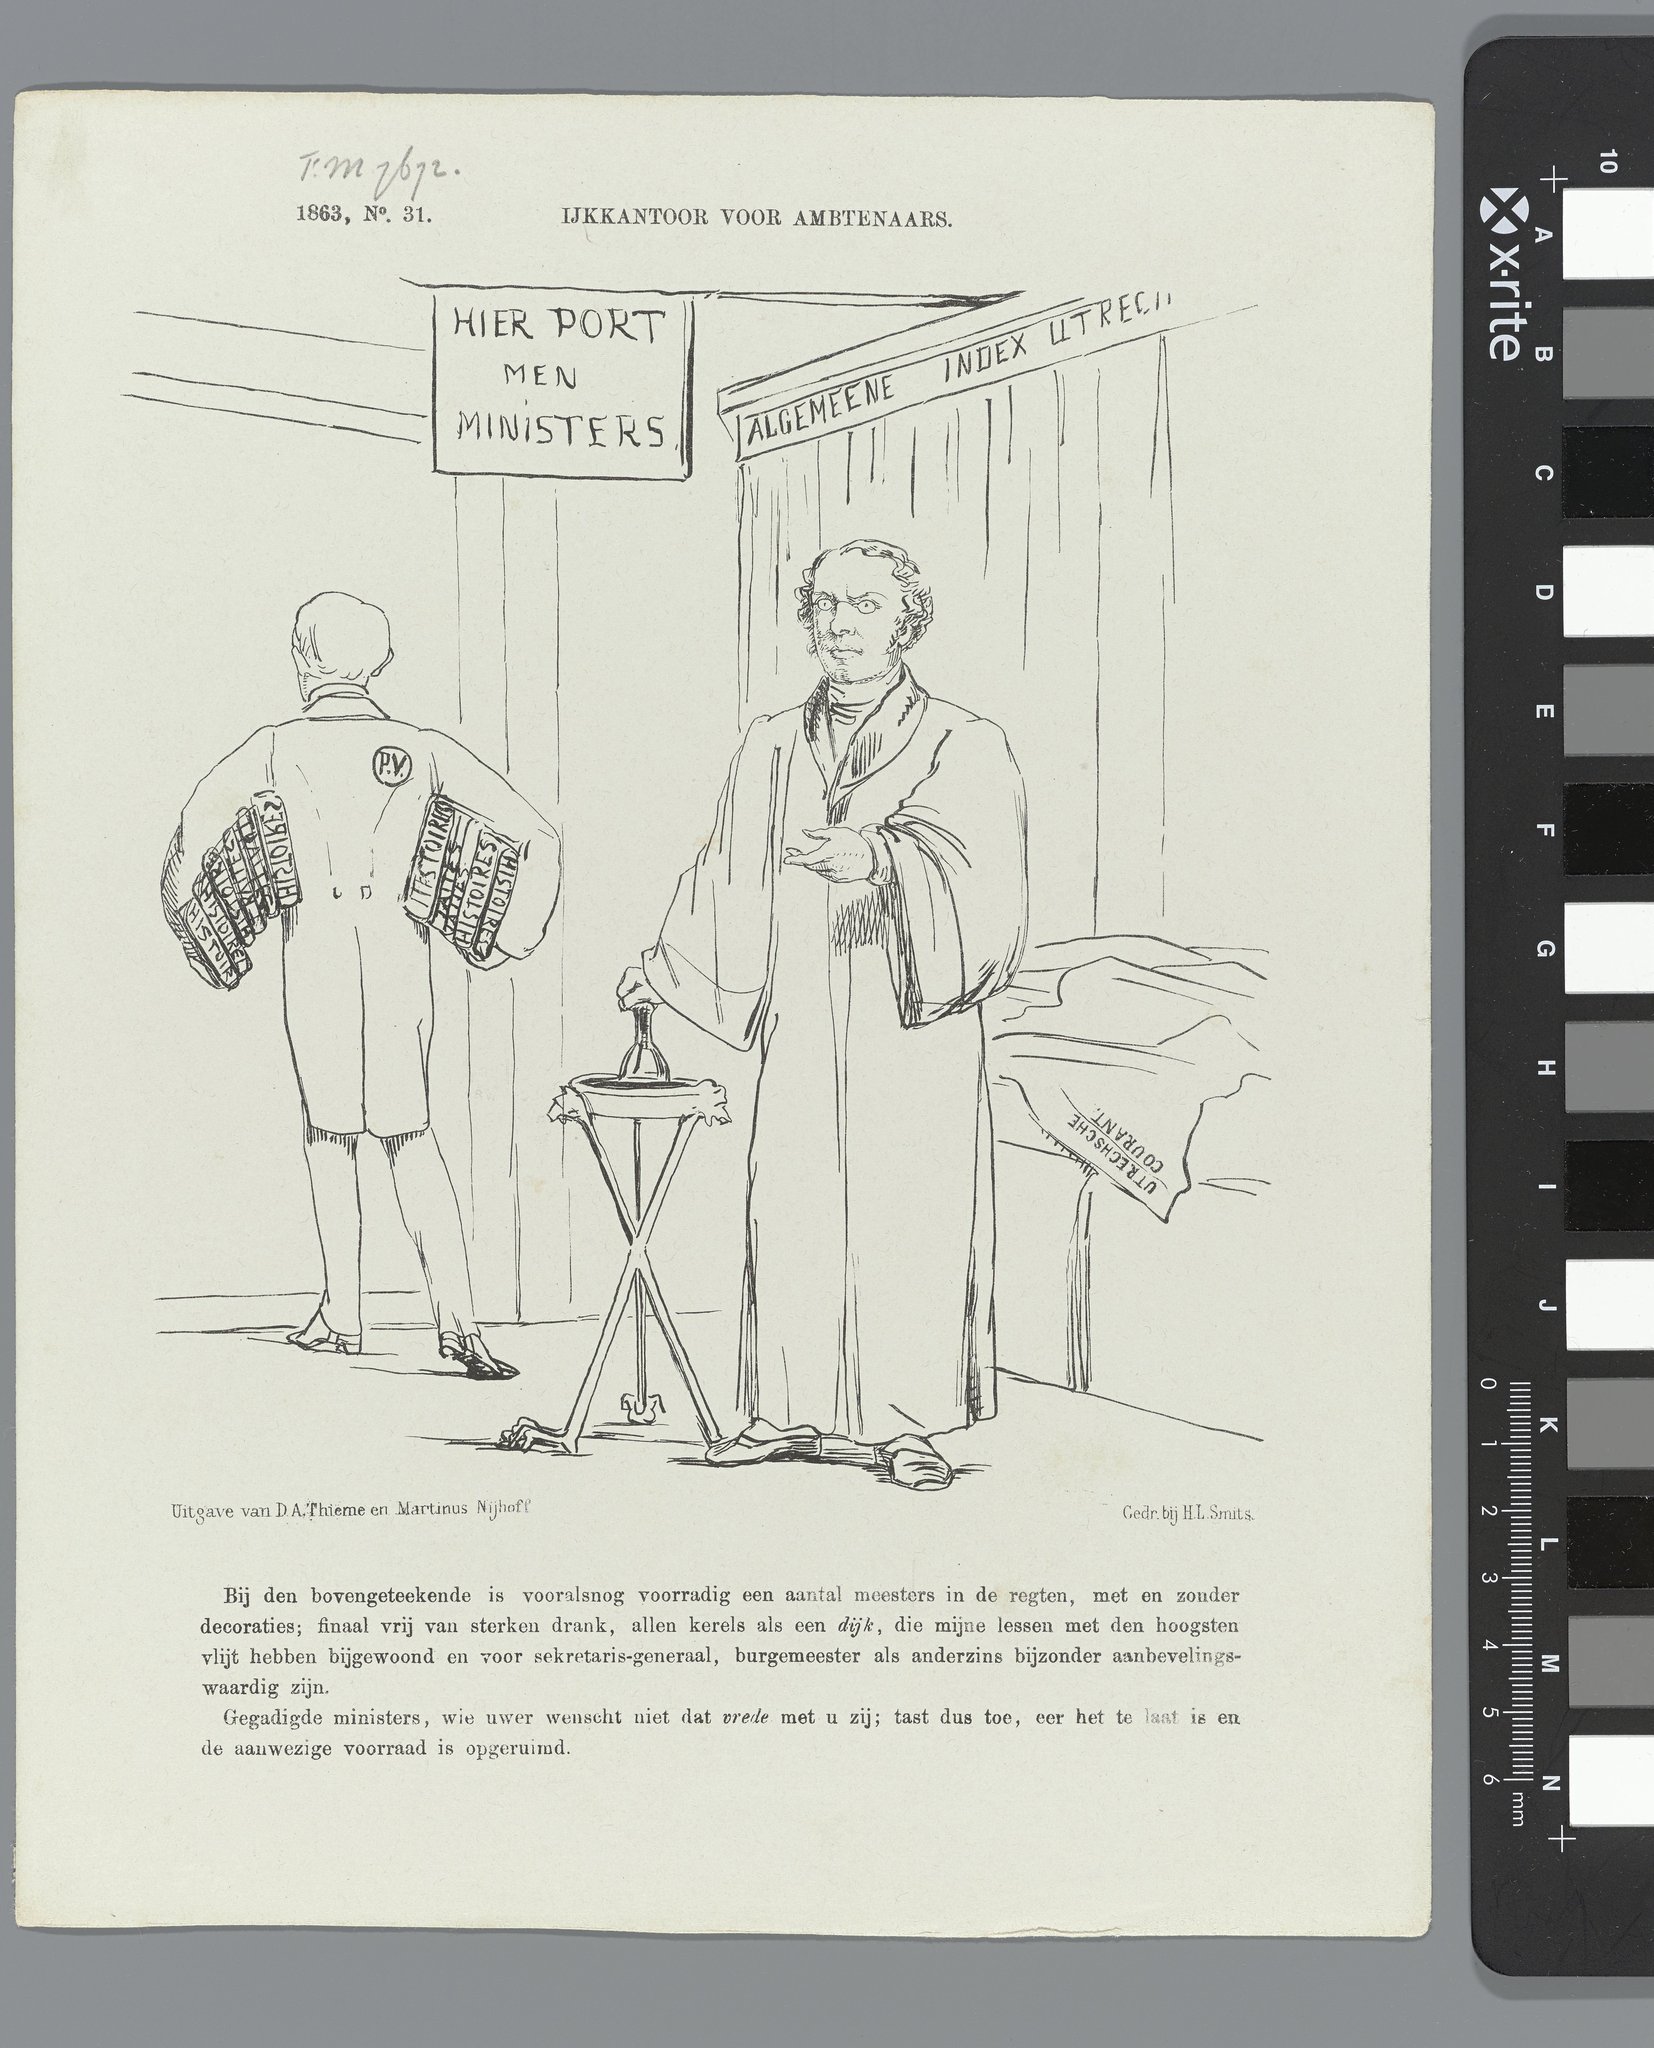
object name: cartoon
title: IJkkantoor voor ambtenaars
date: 1863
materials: paper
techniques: lithograph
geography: netherlands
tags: utrecht, george willem vreede, professor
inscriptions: collector's mark: Lugt 2228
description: Spotprent op de Utrechtse professor Vreede die studenten van een keurmerk voorziet. Plaat verschenen bij het weekblad De Nederlandsche Spectator, nr. 31, 1 augustus 1863.